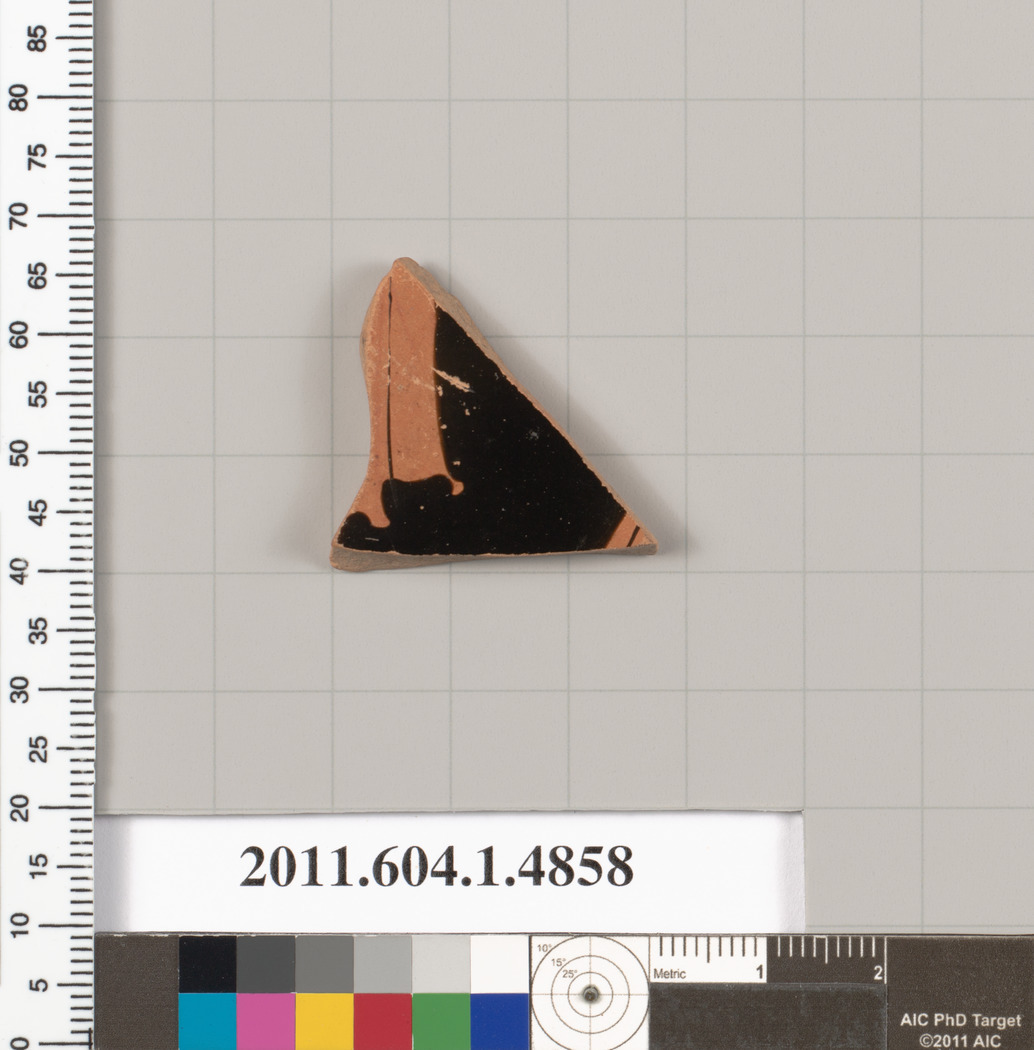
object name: kylix fragment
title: Terracotta fragment of a kylix (drinking cup)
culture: greek, attic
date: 475-451 BCE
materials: terracotta